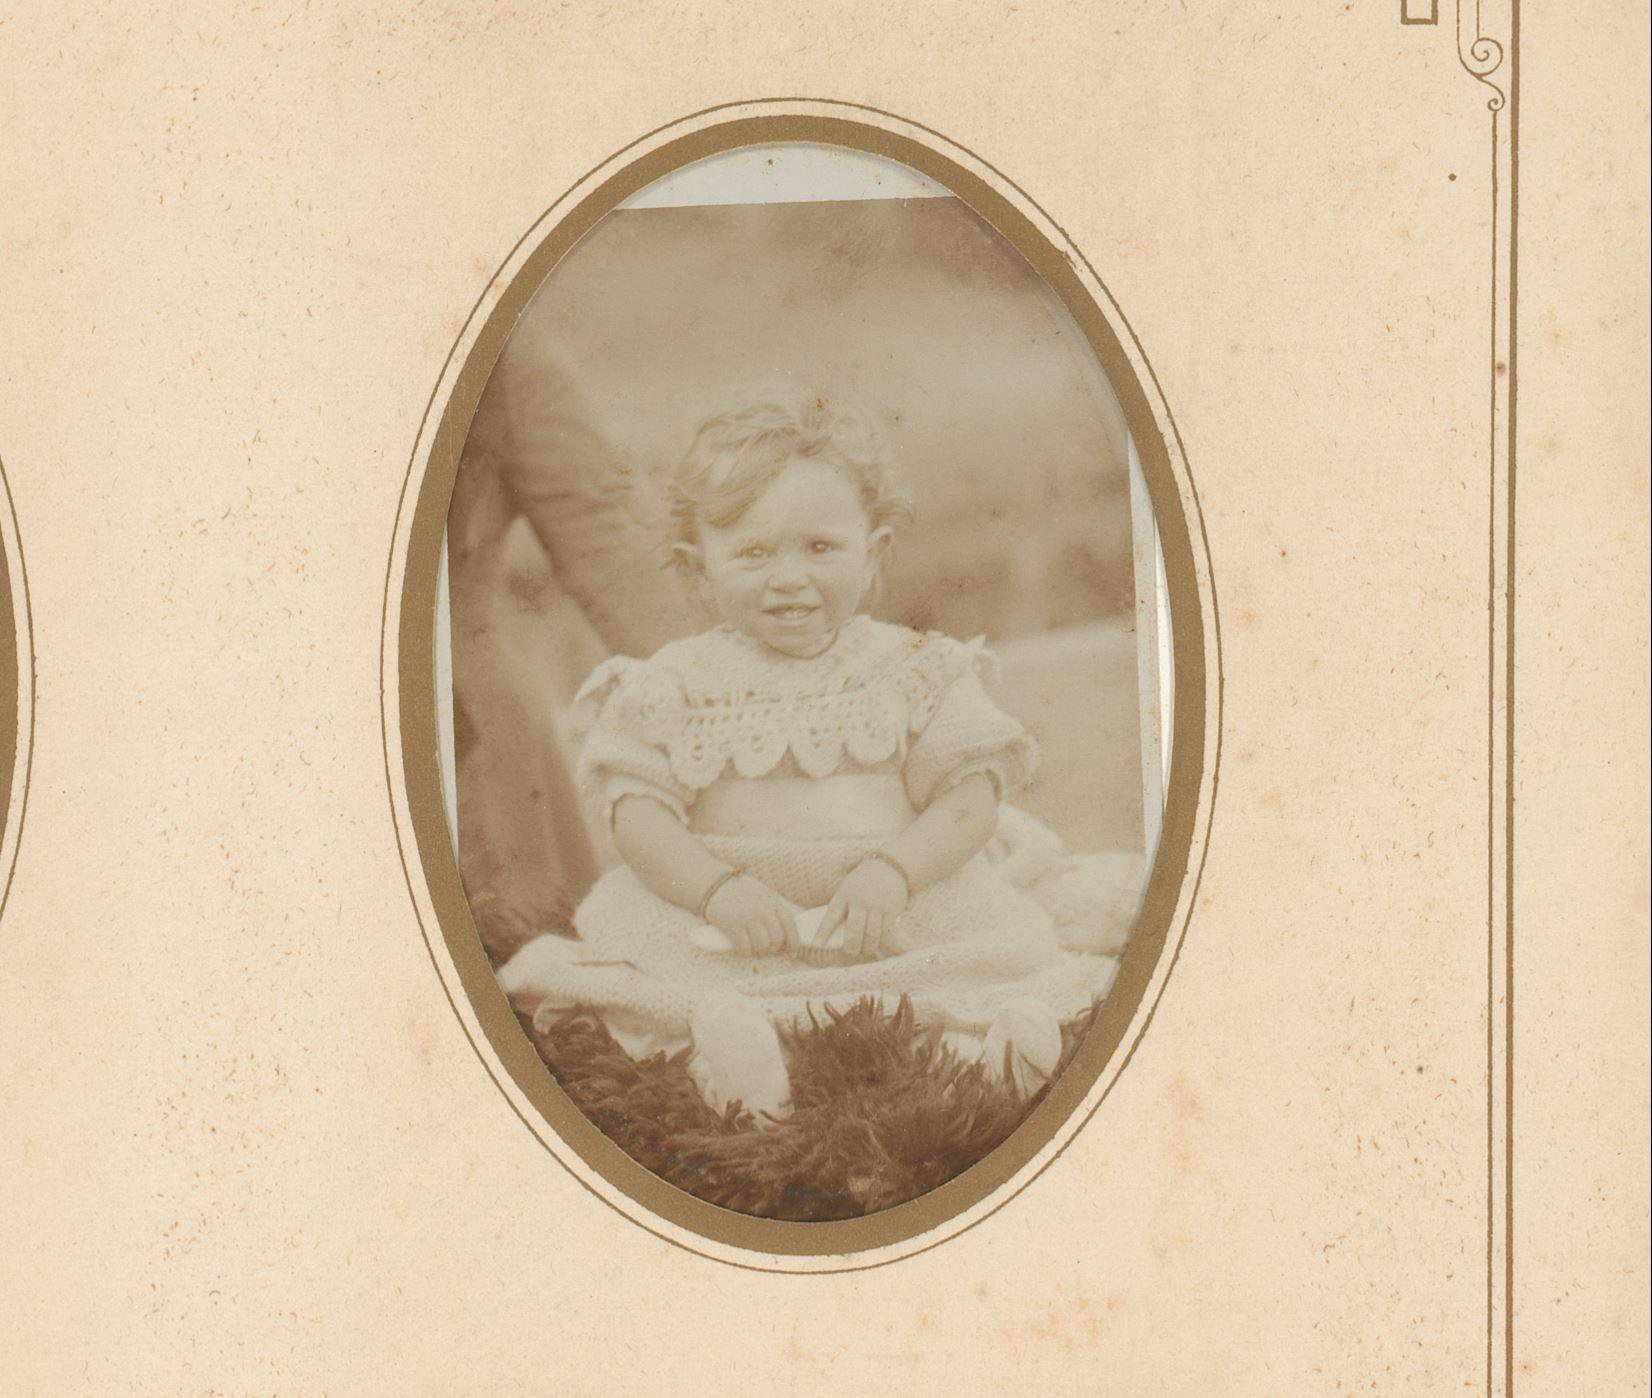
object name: photograph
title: Portret van een baby, zittend maar steunend op moeders arm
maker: Anonymous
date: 1902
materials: cardboard, photographic support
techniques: collodion silver print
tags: historical persons, mother and baby or young child, infant, baby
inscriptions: annotation: ‘Riekje, 1 mrt 1902’